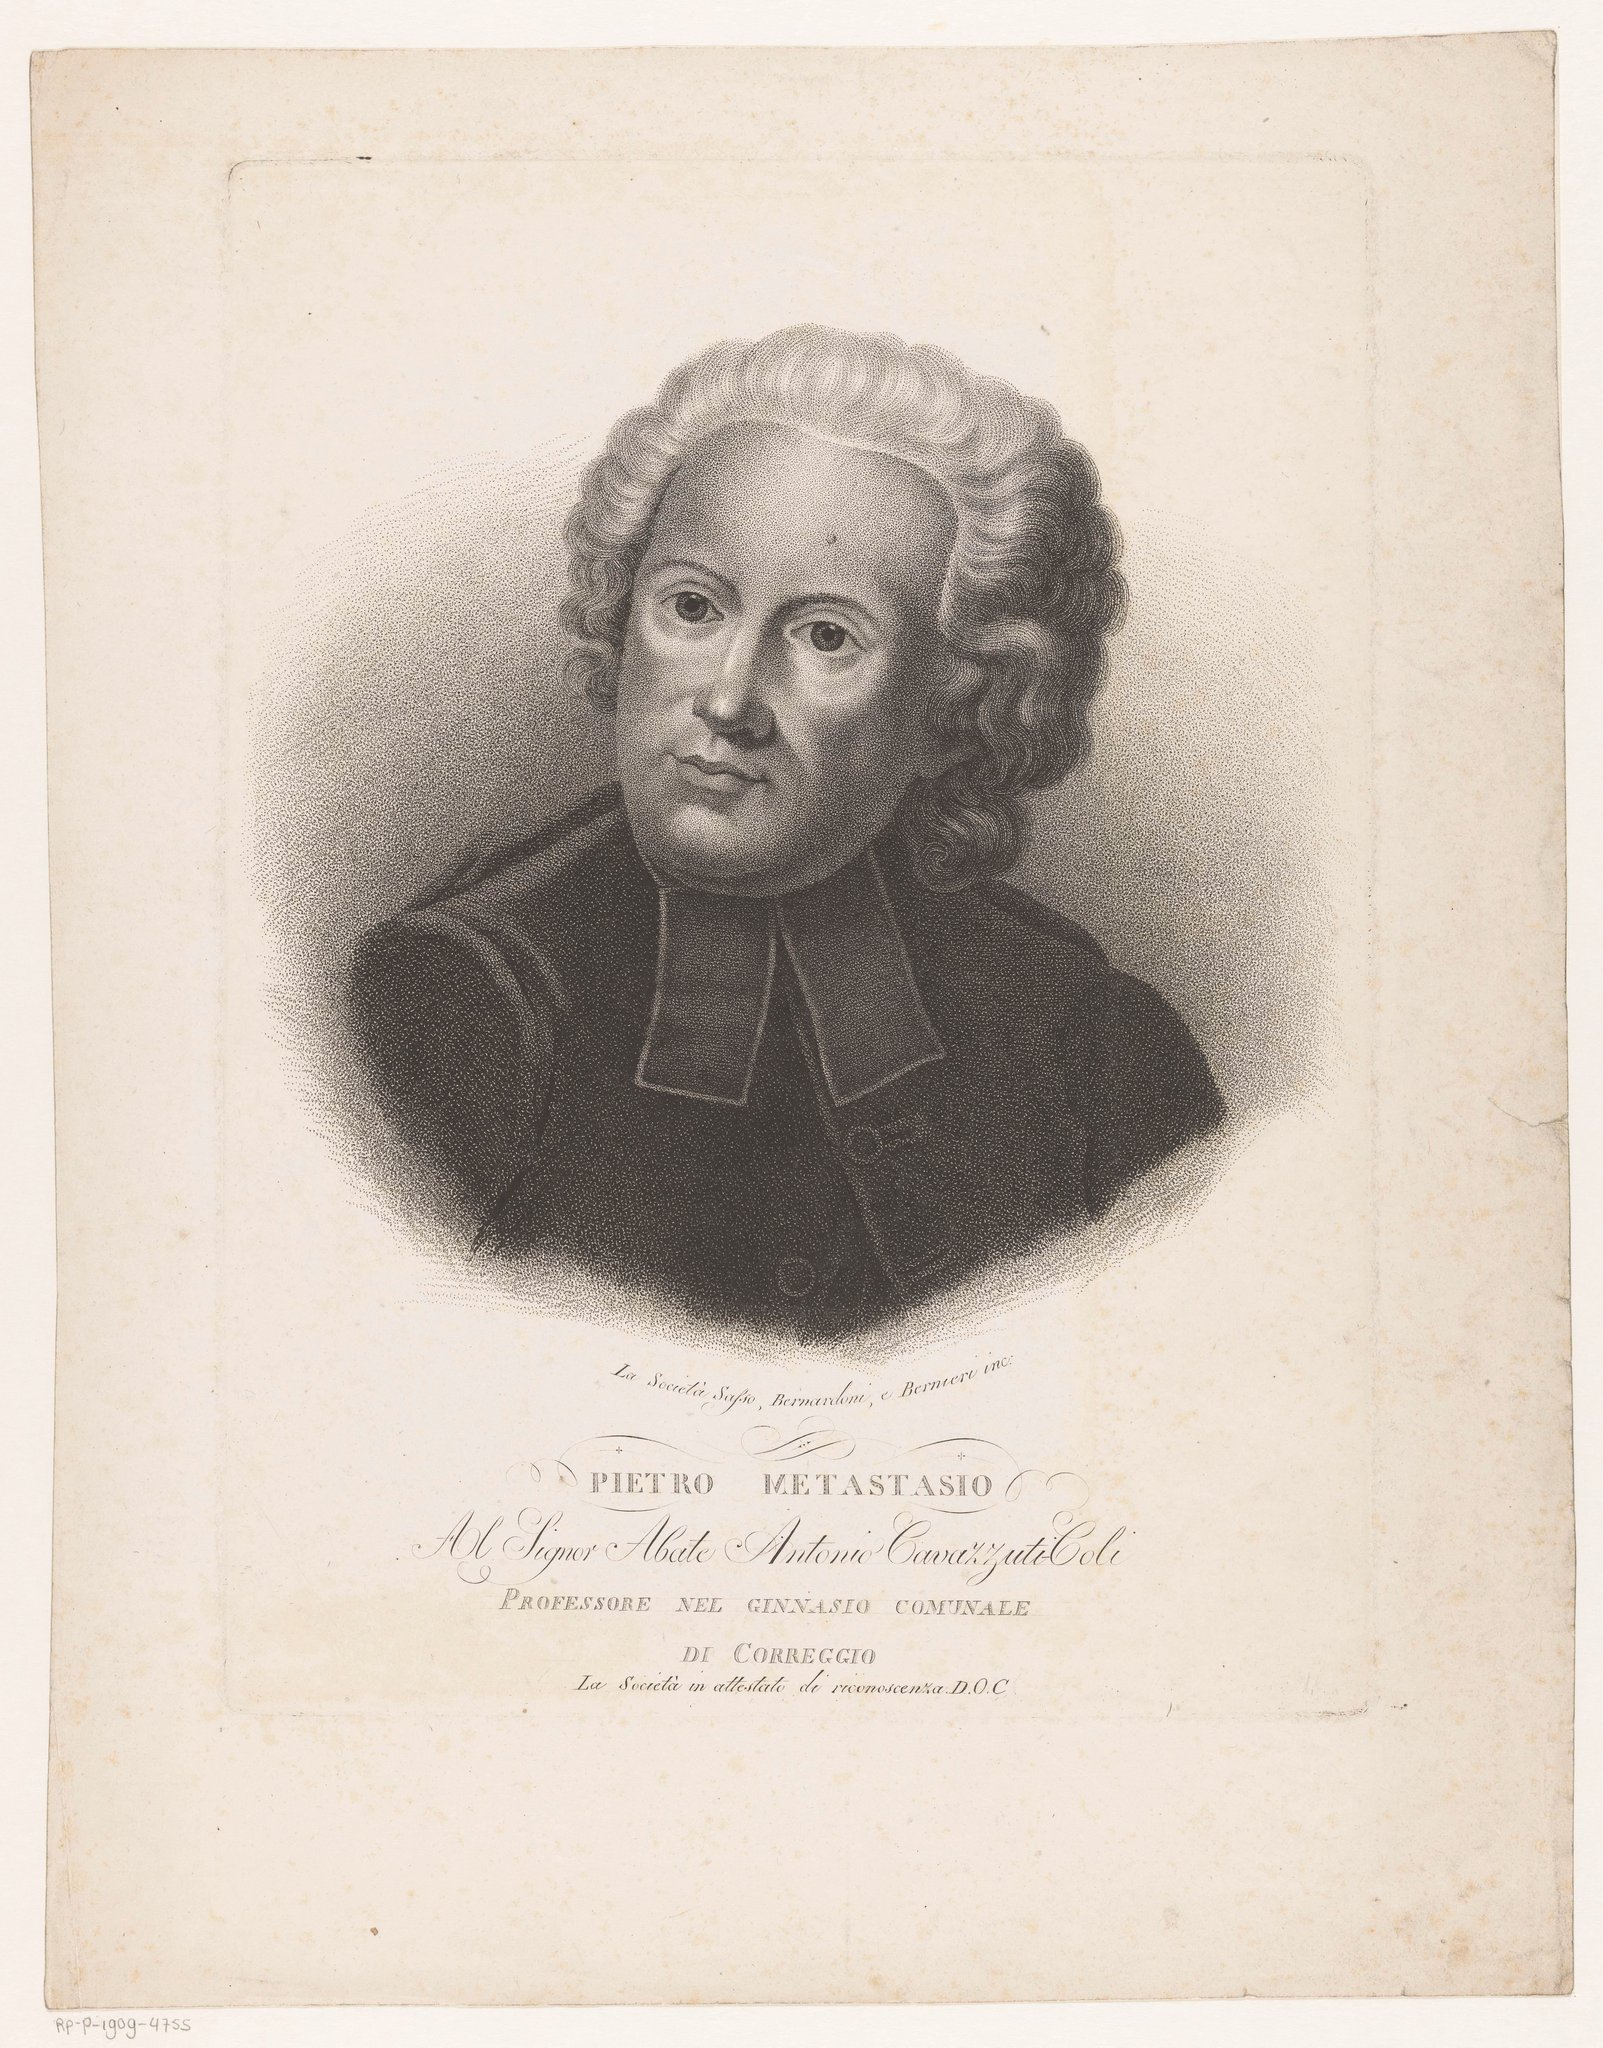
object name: print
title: Portret van librettist Pietro Metastasio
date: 1802-1871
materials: paper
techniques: engraving, etching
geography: italy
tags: rome, historical persons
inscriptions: collector's mark: Lugt 2228